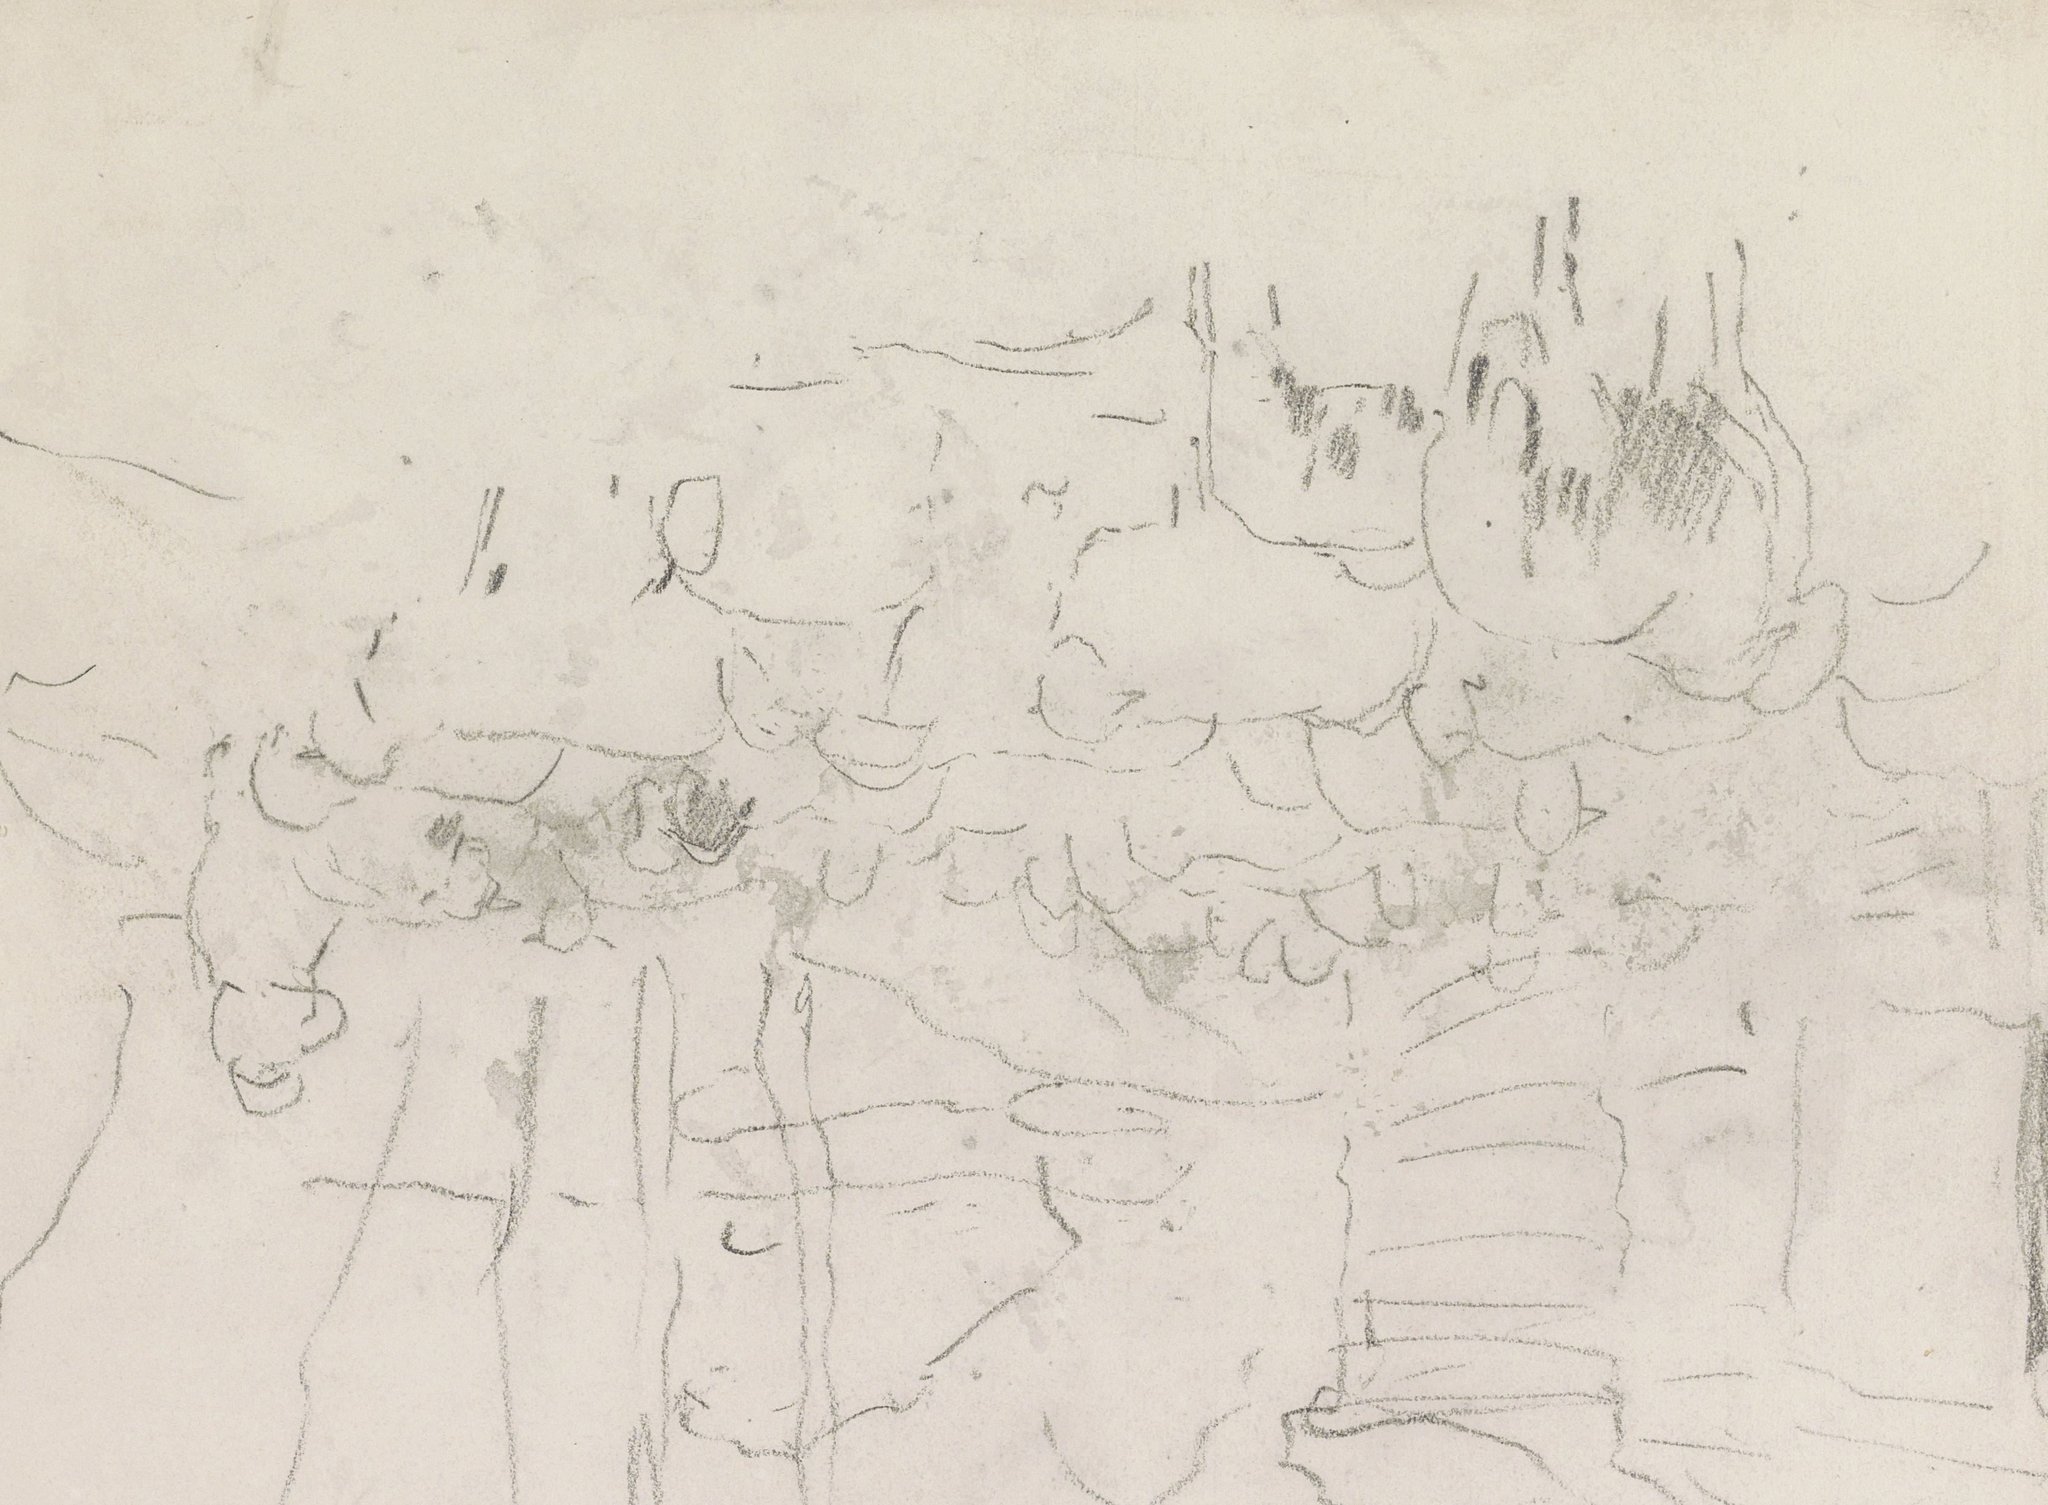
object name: sketchbook leaf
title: Herder met een schaapskudde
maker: anton mauve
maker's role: draughtsman, painter, print maker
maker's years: 1838-1888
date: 1886-1888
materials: chalk, paper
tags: herding, herdsman, herdswoman, shepherd, shepherdess, cowherd, etc., sheep, herd, flock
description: Vermoedelijk staan de schapen bij een stal. Blad 3 recto uit een schetsboek met 27 bladen.